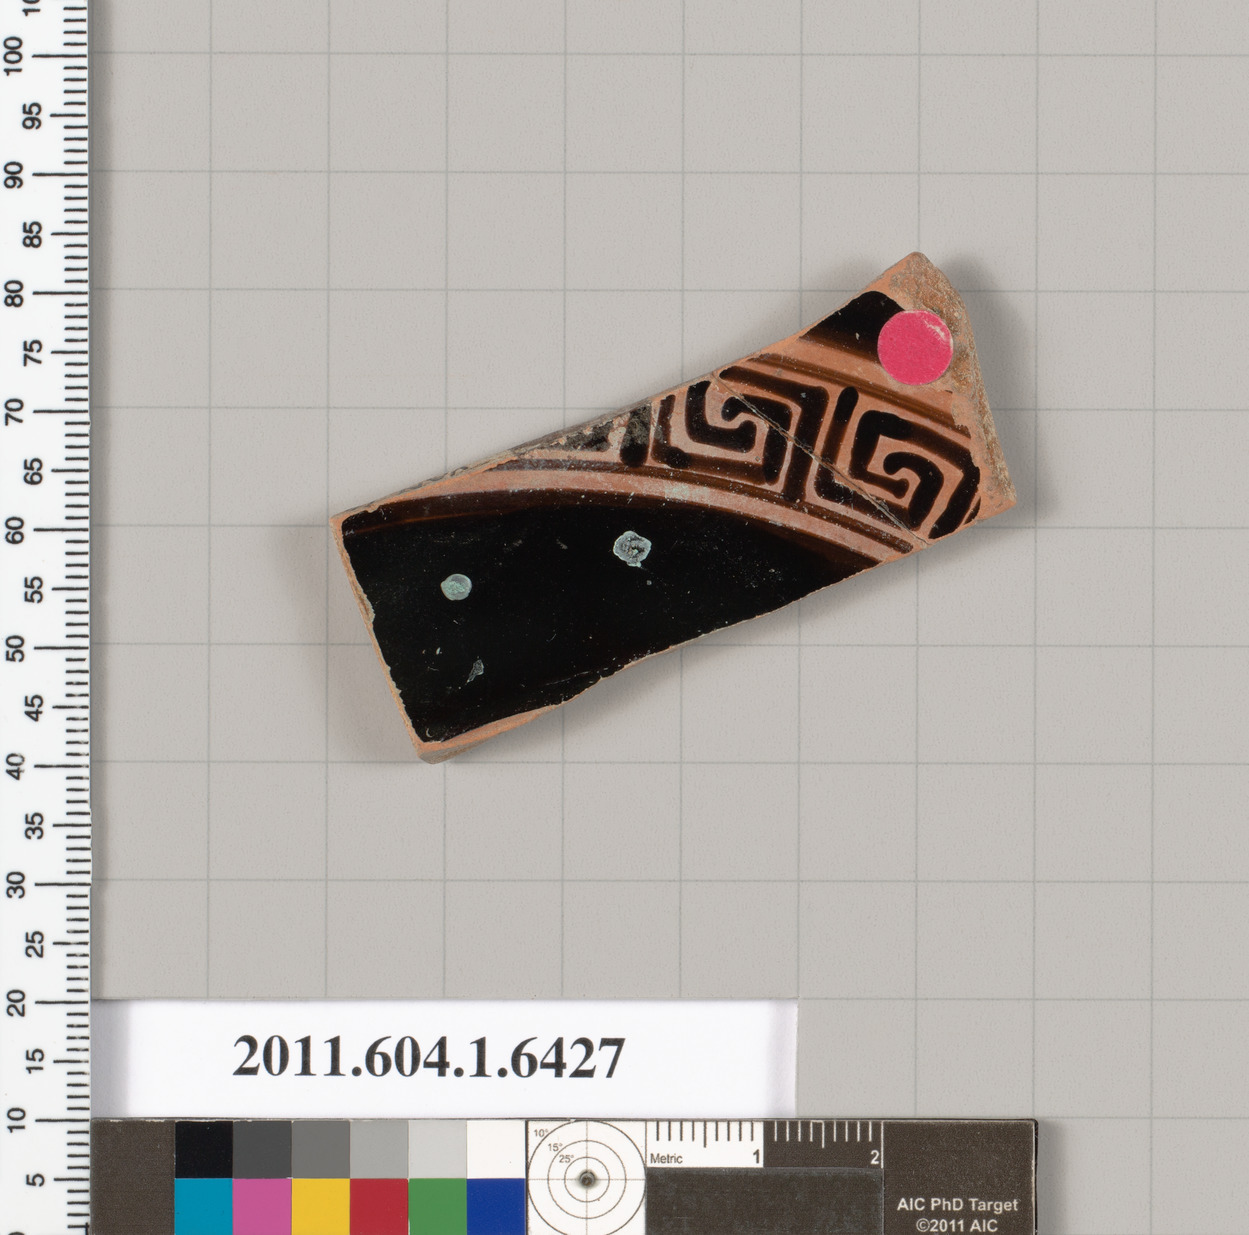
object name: kylix fragment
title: Terracotta fragment of a kylix (drinking cup)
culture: greek, attic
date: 490-480 BCE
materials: terracotta